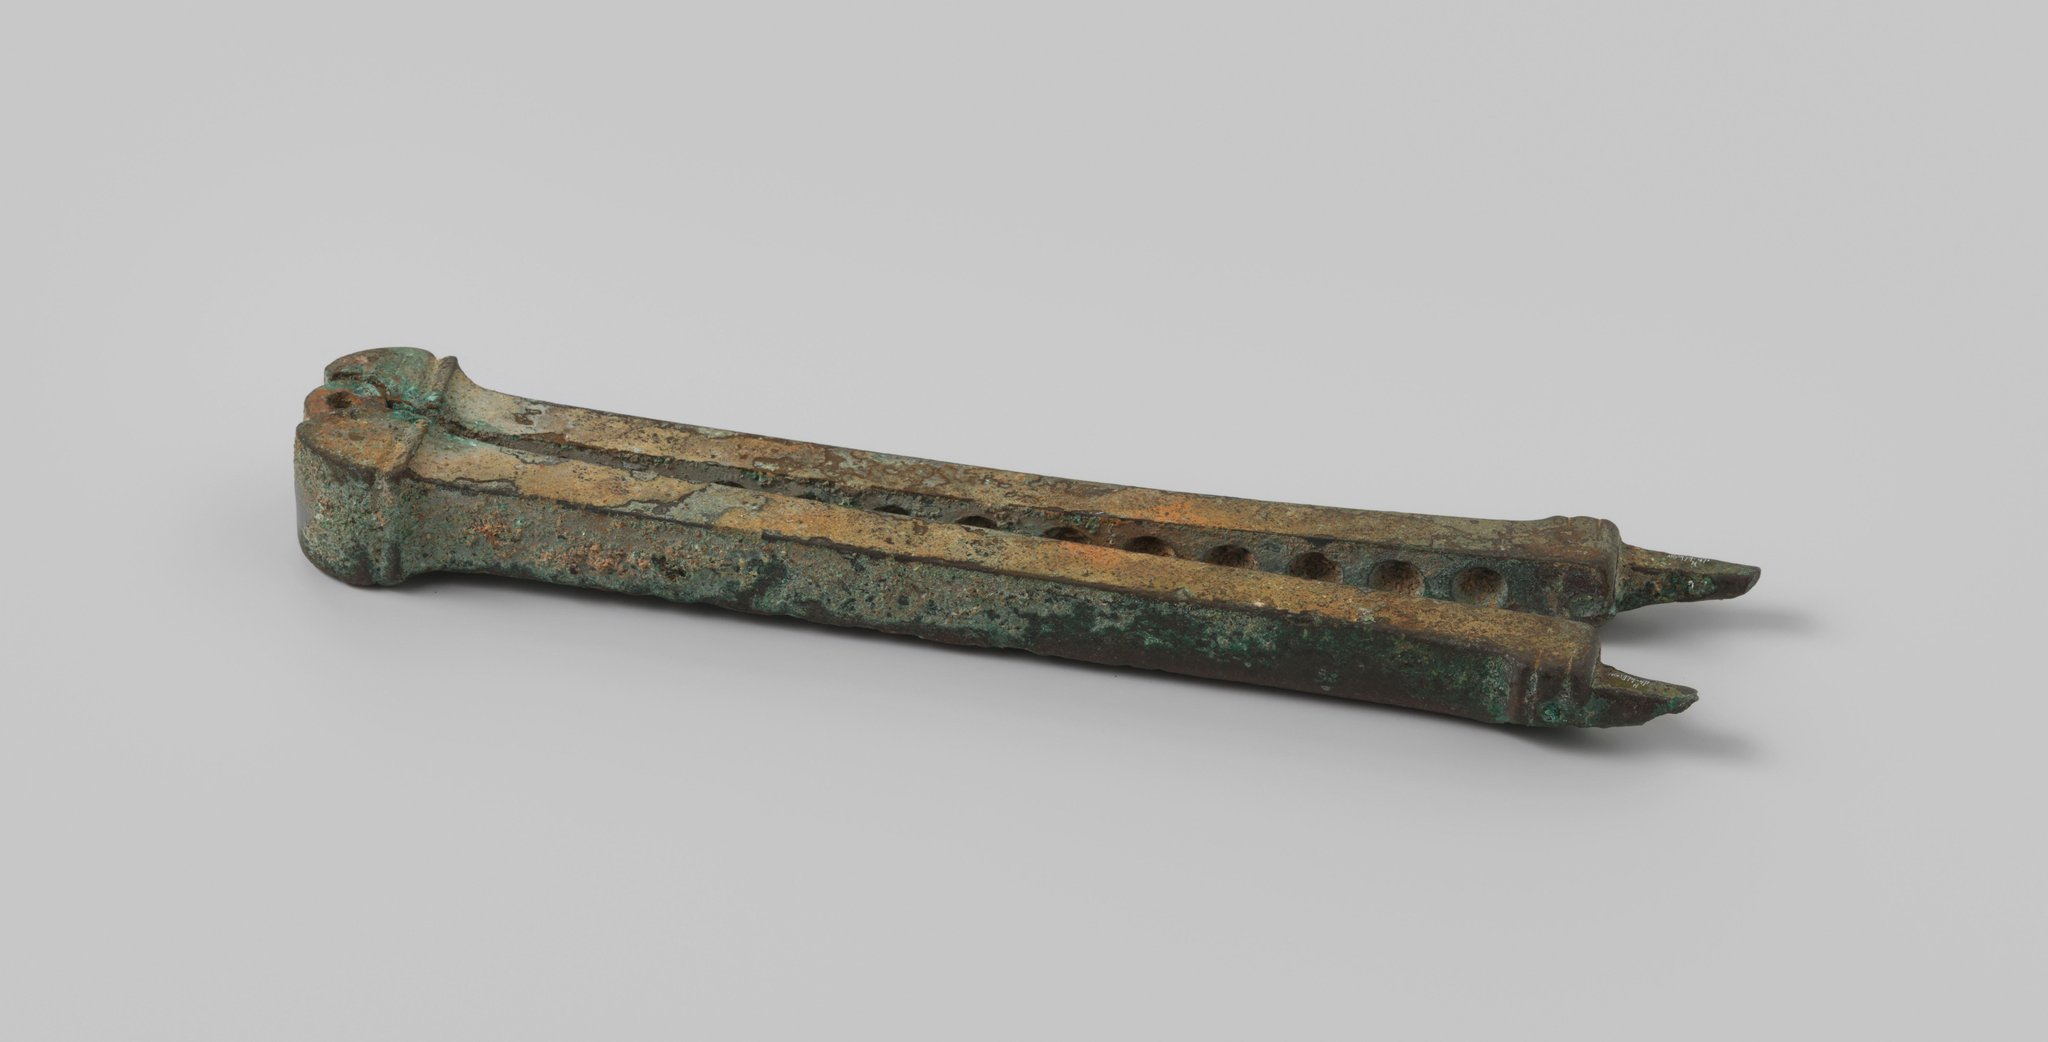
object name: bullet mould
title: Giettang voor musketkogels uit het wrak van de Oost-Indiëvaarder Hollandia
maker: Anonymous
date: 1700-1743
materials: copper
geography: netherlands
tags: verenigde oostindische compagnie, hollandia (schip), annet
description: Shotmould; id. NG 1975-45H, eroded, one tang missing. Gemerkt: XXIIII.